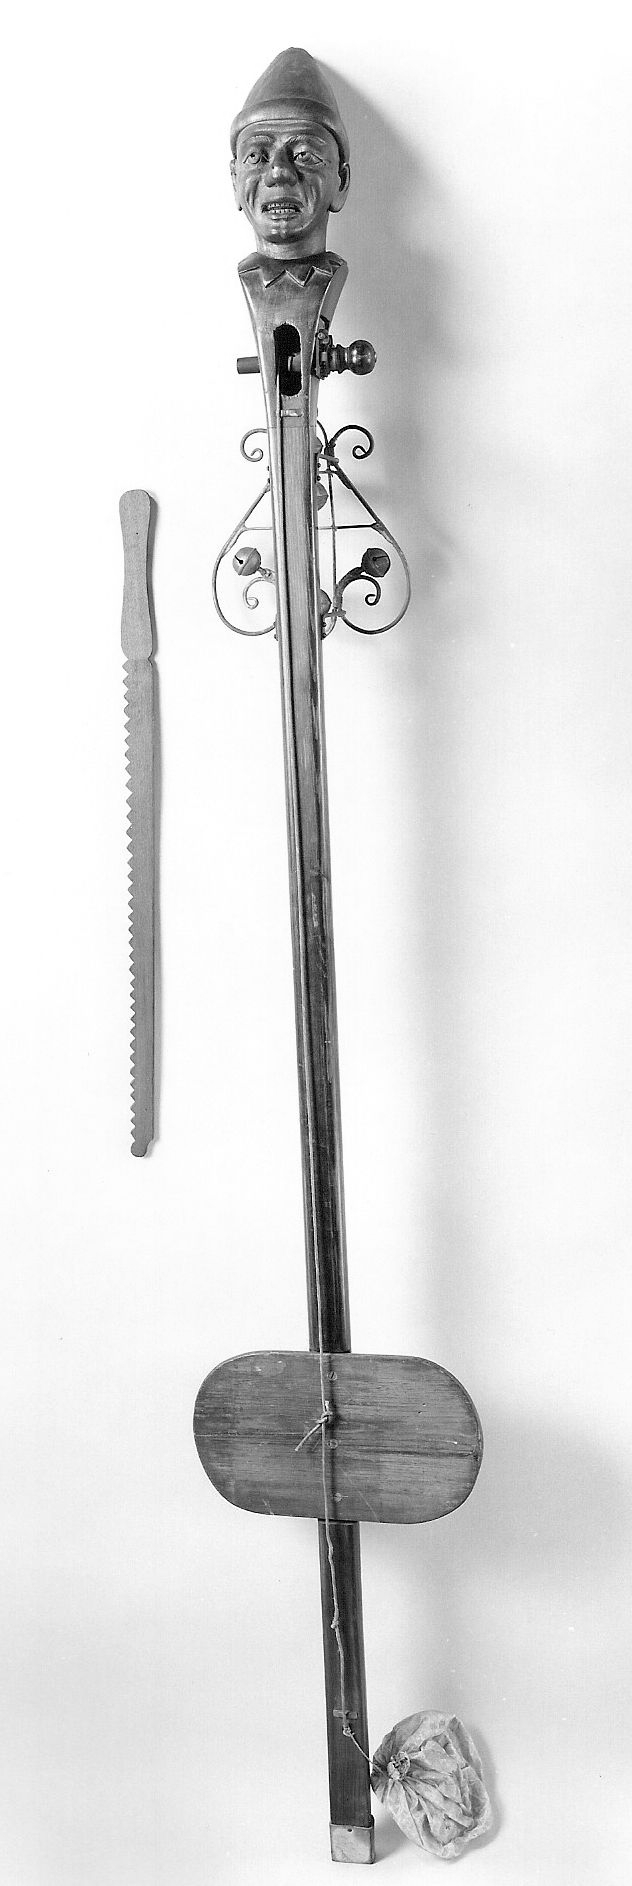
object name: bumbass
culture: american or german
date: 1867-1900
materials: metal, skin, wood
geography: united states